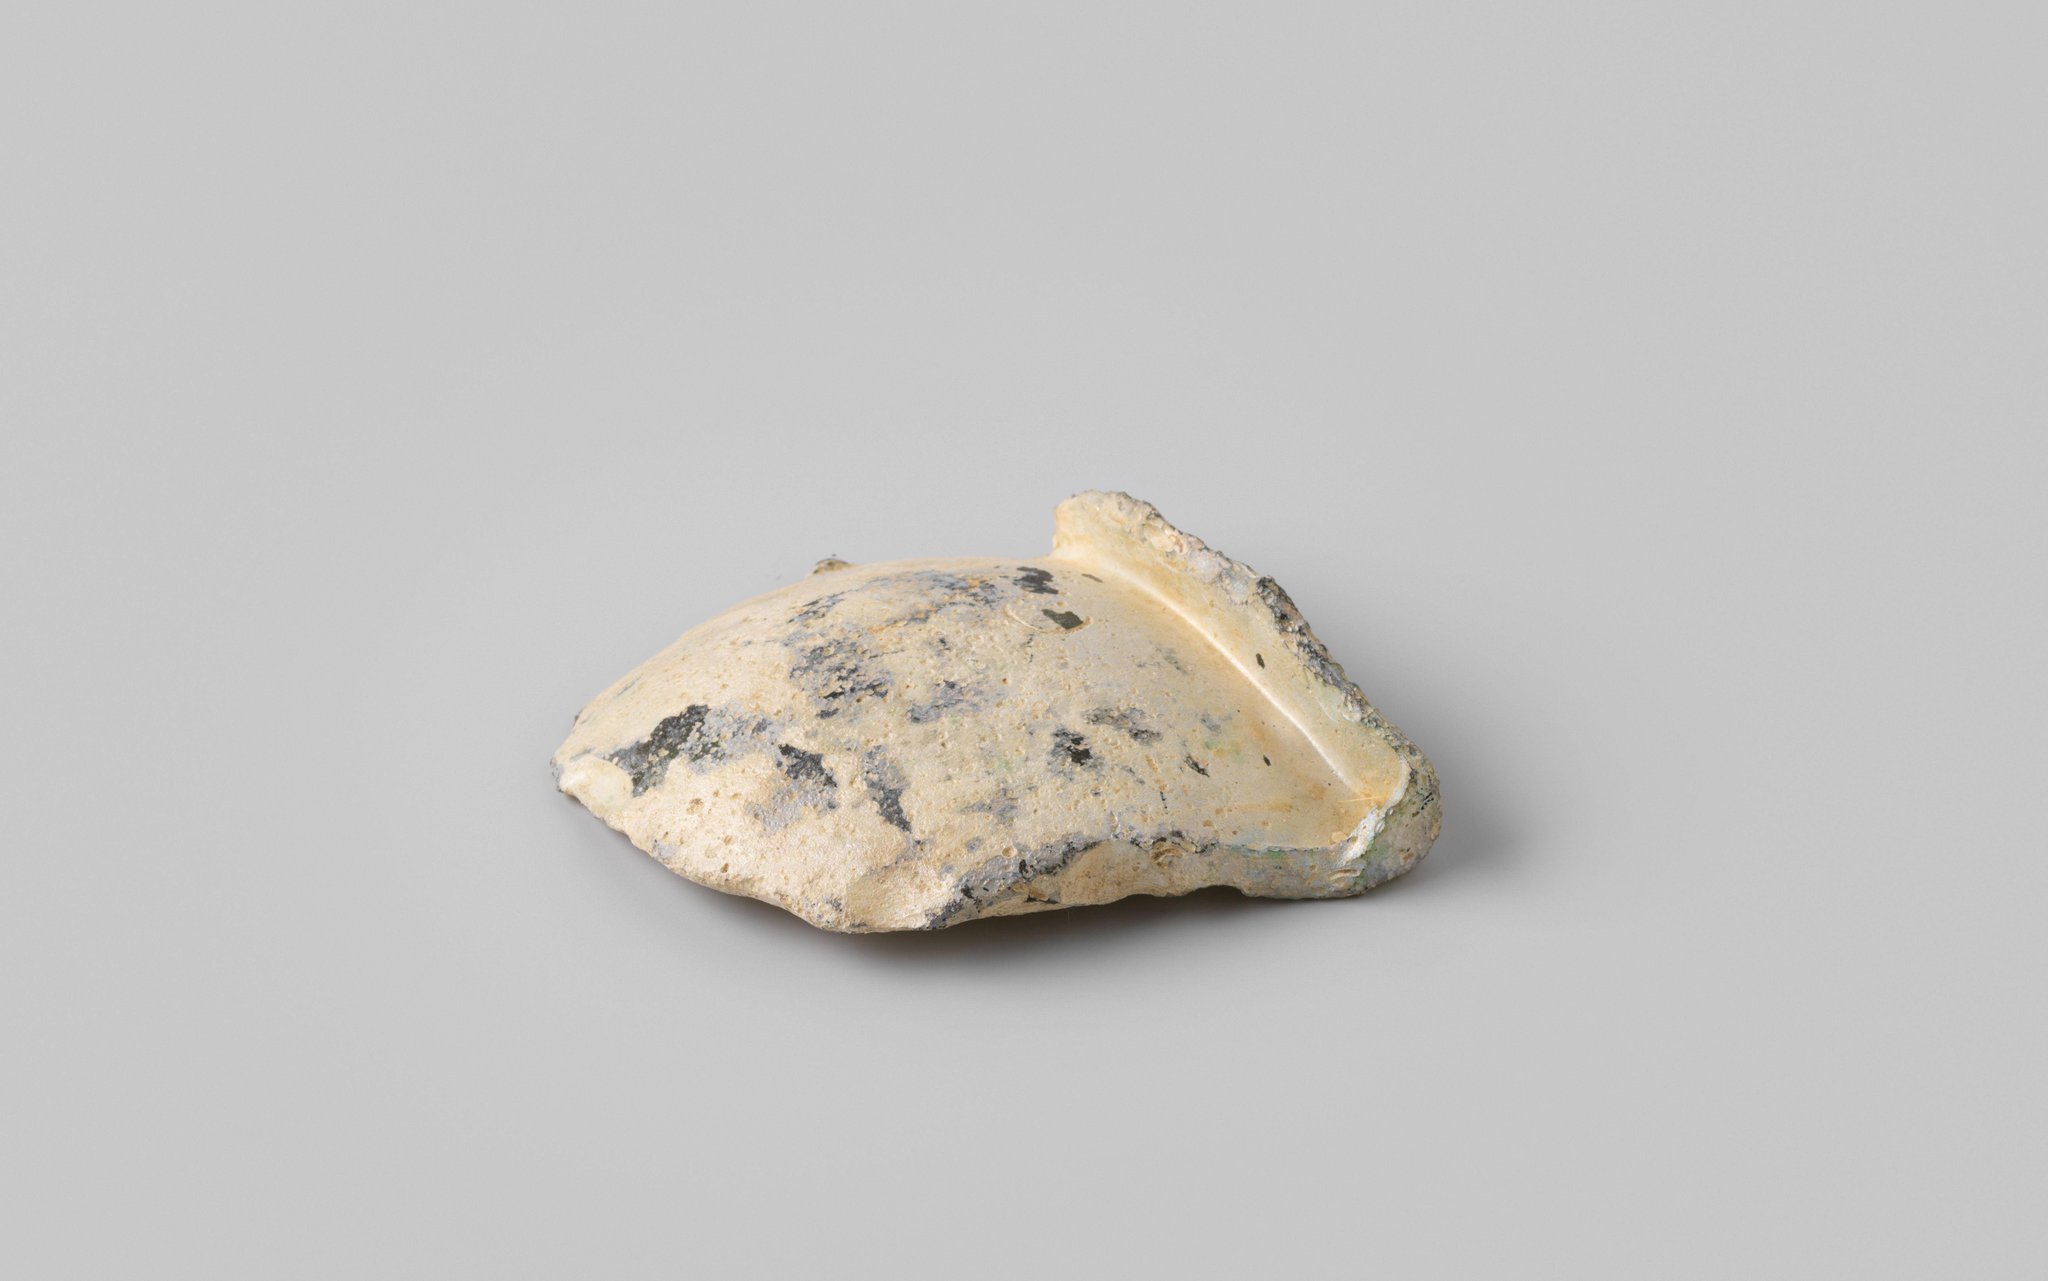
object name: case bottle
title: Scherf van een kelderfles uit het wrak van de Oost-Indiëvaarder Hollandia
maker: Anonymous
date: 1700-1743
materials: glass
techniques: green glass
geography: netherlands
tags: verenigde oostindische compagnie, hollandia (schip), annet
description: Case bottle, fragm of base, sim. NG 1980-27H1872b, eroded.